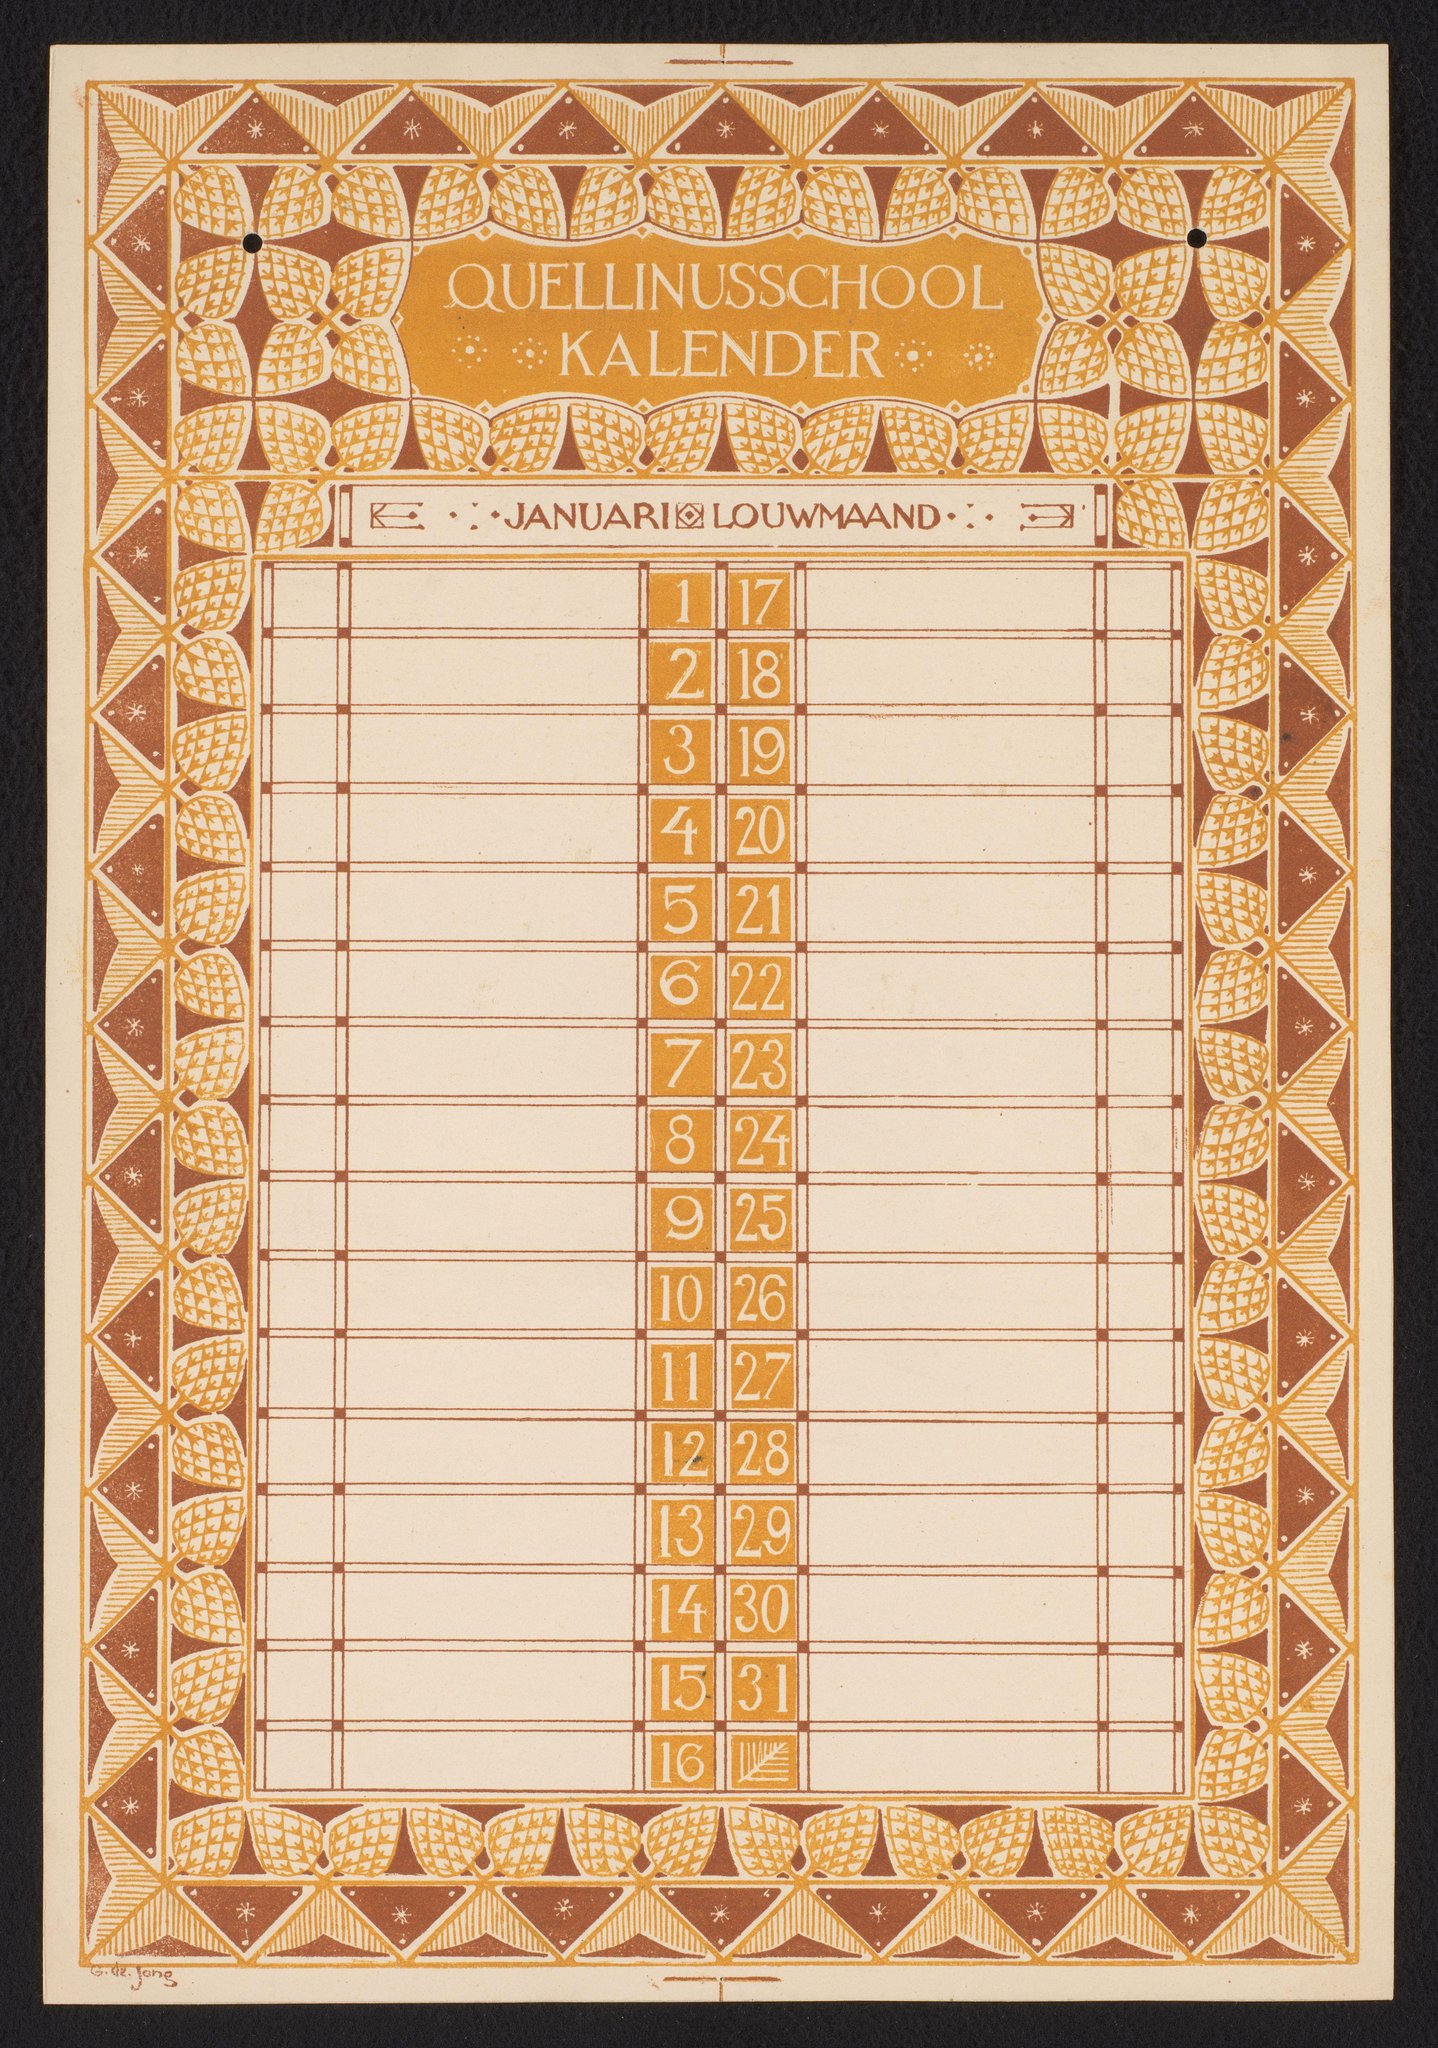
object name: calendar leaf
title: Kalenderblad voor de louwmaand, januari, van een kalender van Kunstnijverheidsschool Quellinus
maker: g. de jong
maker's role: print maker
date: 1885-1925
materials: paper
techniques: lithograph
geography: amsterdam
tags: calendar, almanac, fruits: pine-cone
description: Bij gebrek aan gegevens over de vervaardiger is voor de bepaling van de rechten van dit object gebruik gemaakt van de vervaardigingsdatum.